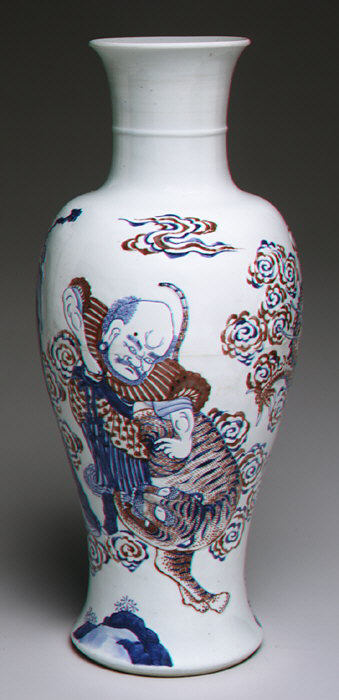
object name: vase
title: Vase with Buddhist figures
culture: chinese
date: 1667-1700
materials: cobalt, copper, porcelain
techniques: painting, underglaze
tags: men,dragons,tigers